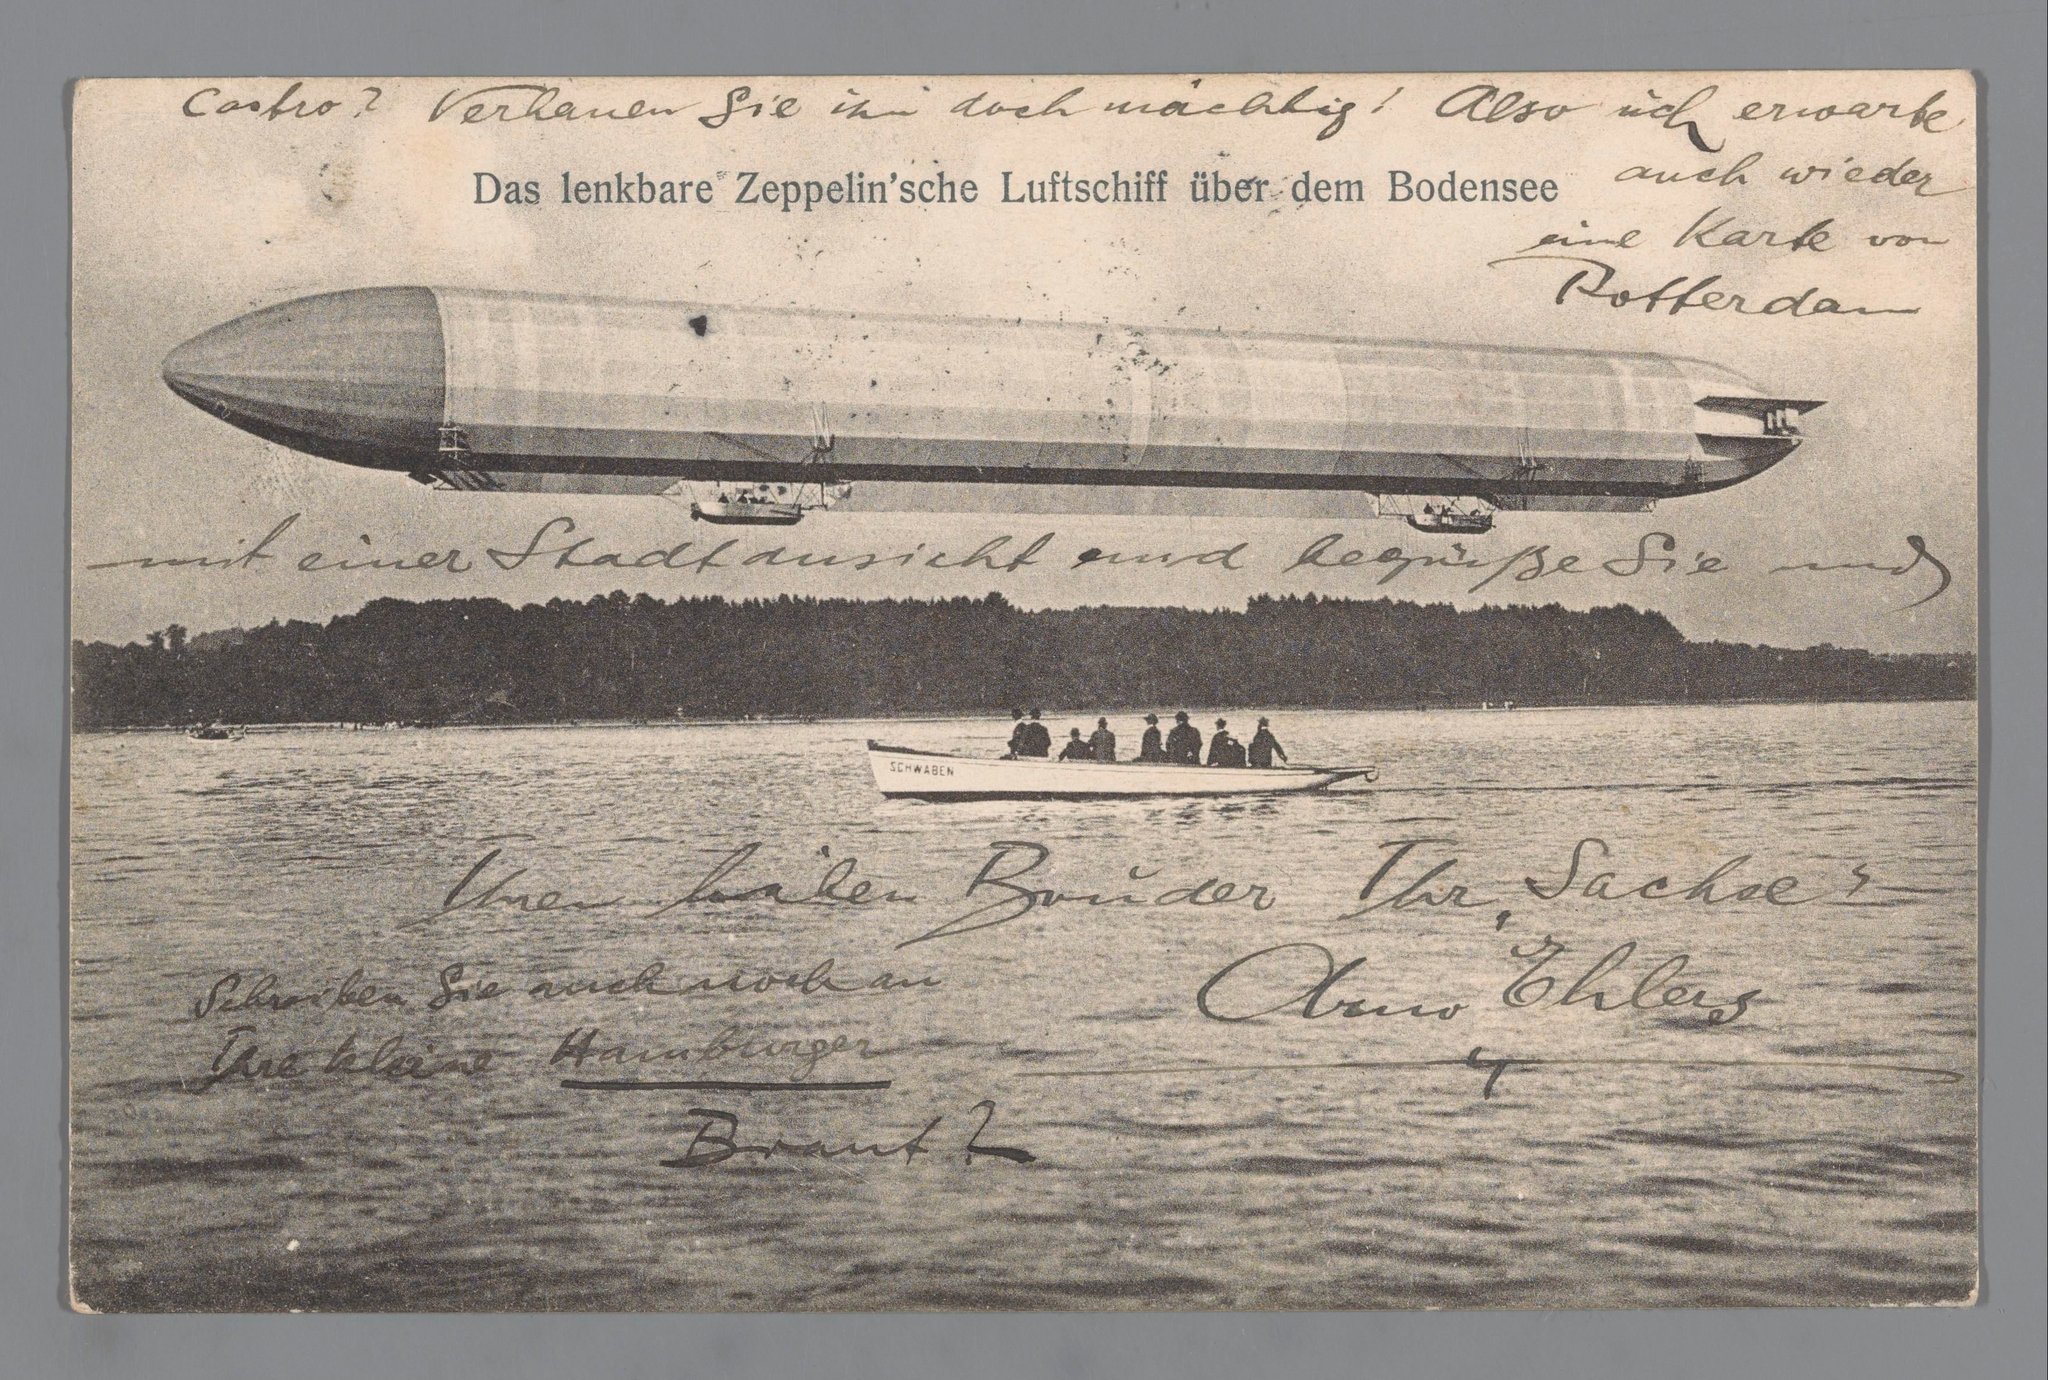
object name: ansichtkaart, prentbriefkaart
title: Das lenkbare Zeppelin'sche Luftschiff über dem Bodensee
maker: Anonymous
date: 1906-1908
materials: paper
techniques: photograph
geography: germany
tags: 46c35 airship, zeppelin, lake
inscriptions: inscription: ‘Castro? (...) Arno Ehlers’, inscription: ‘Absender (...) Rotterdam Schietbaanlaan 96 H’